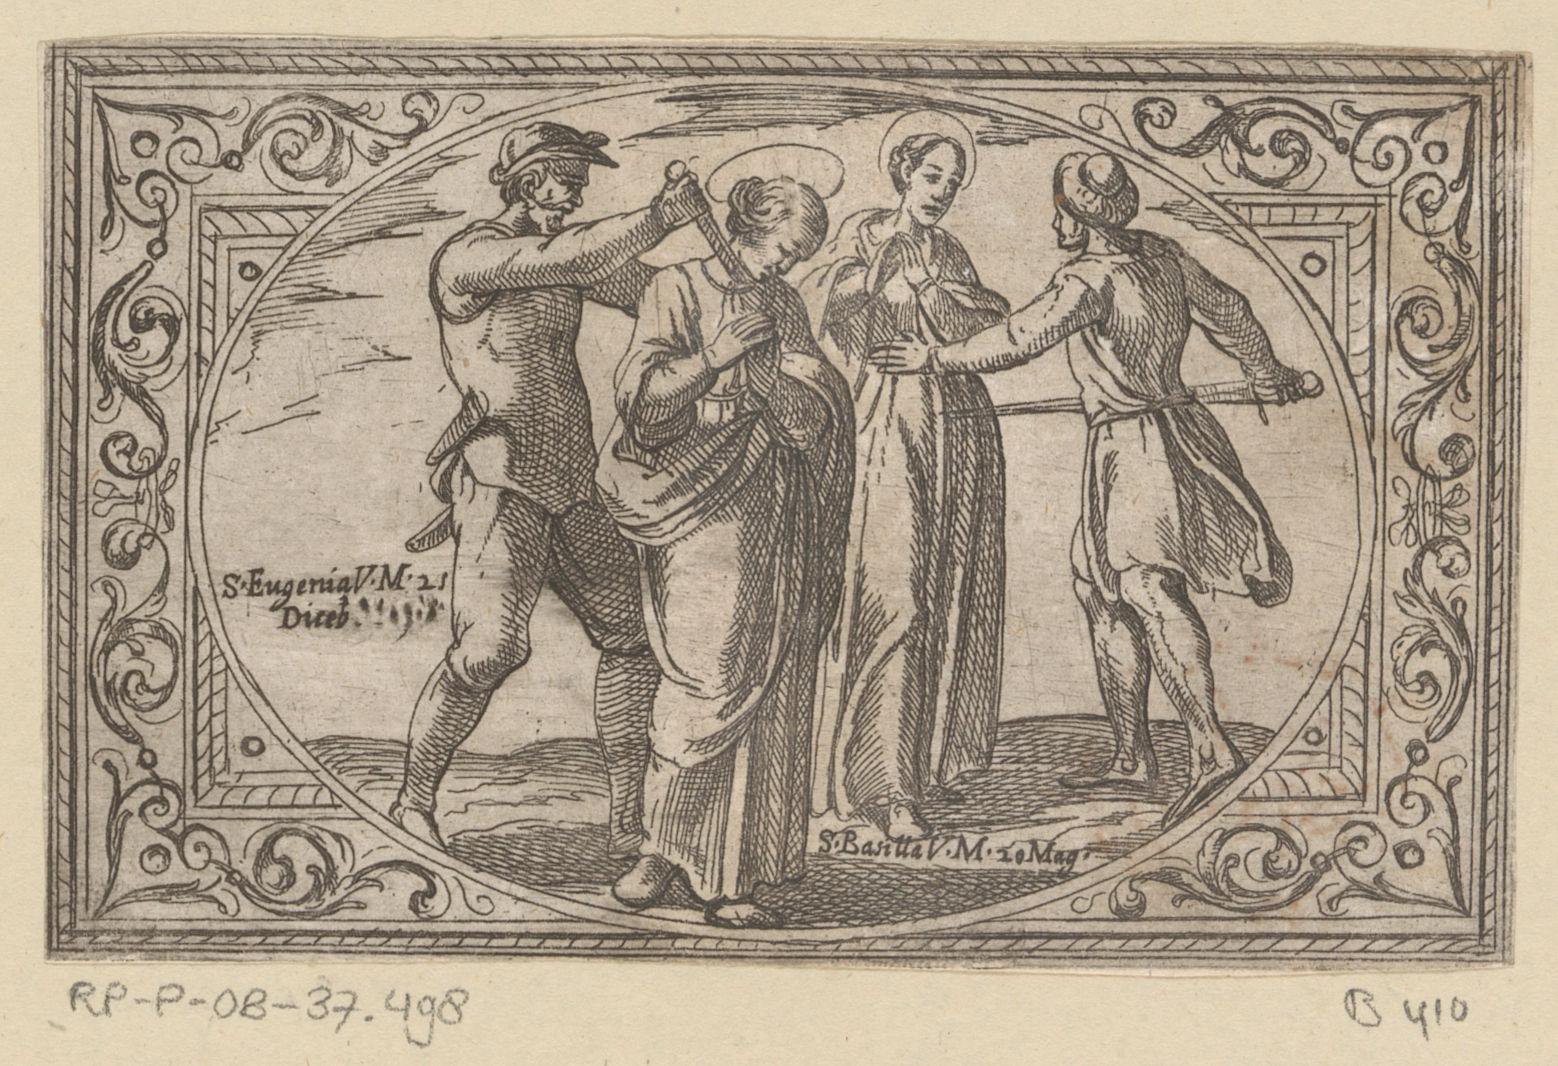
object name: print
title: H. Eugenia en H. Basilla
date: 1565-1630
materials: paper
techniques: etching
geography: rome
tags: martyr(s) (often with palm-branches) - qq - female martyr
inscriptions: collector's mark: Lugt 240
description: Deze prent maakt deel uit van een reeks van 73 prenten (+ titelprent) met voorstellingen van Romeinse martelaressen.